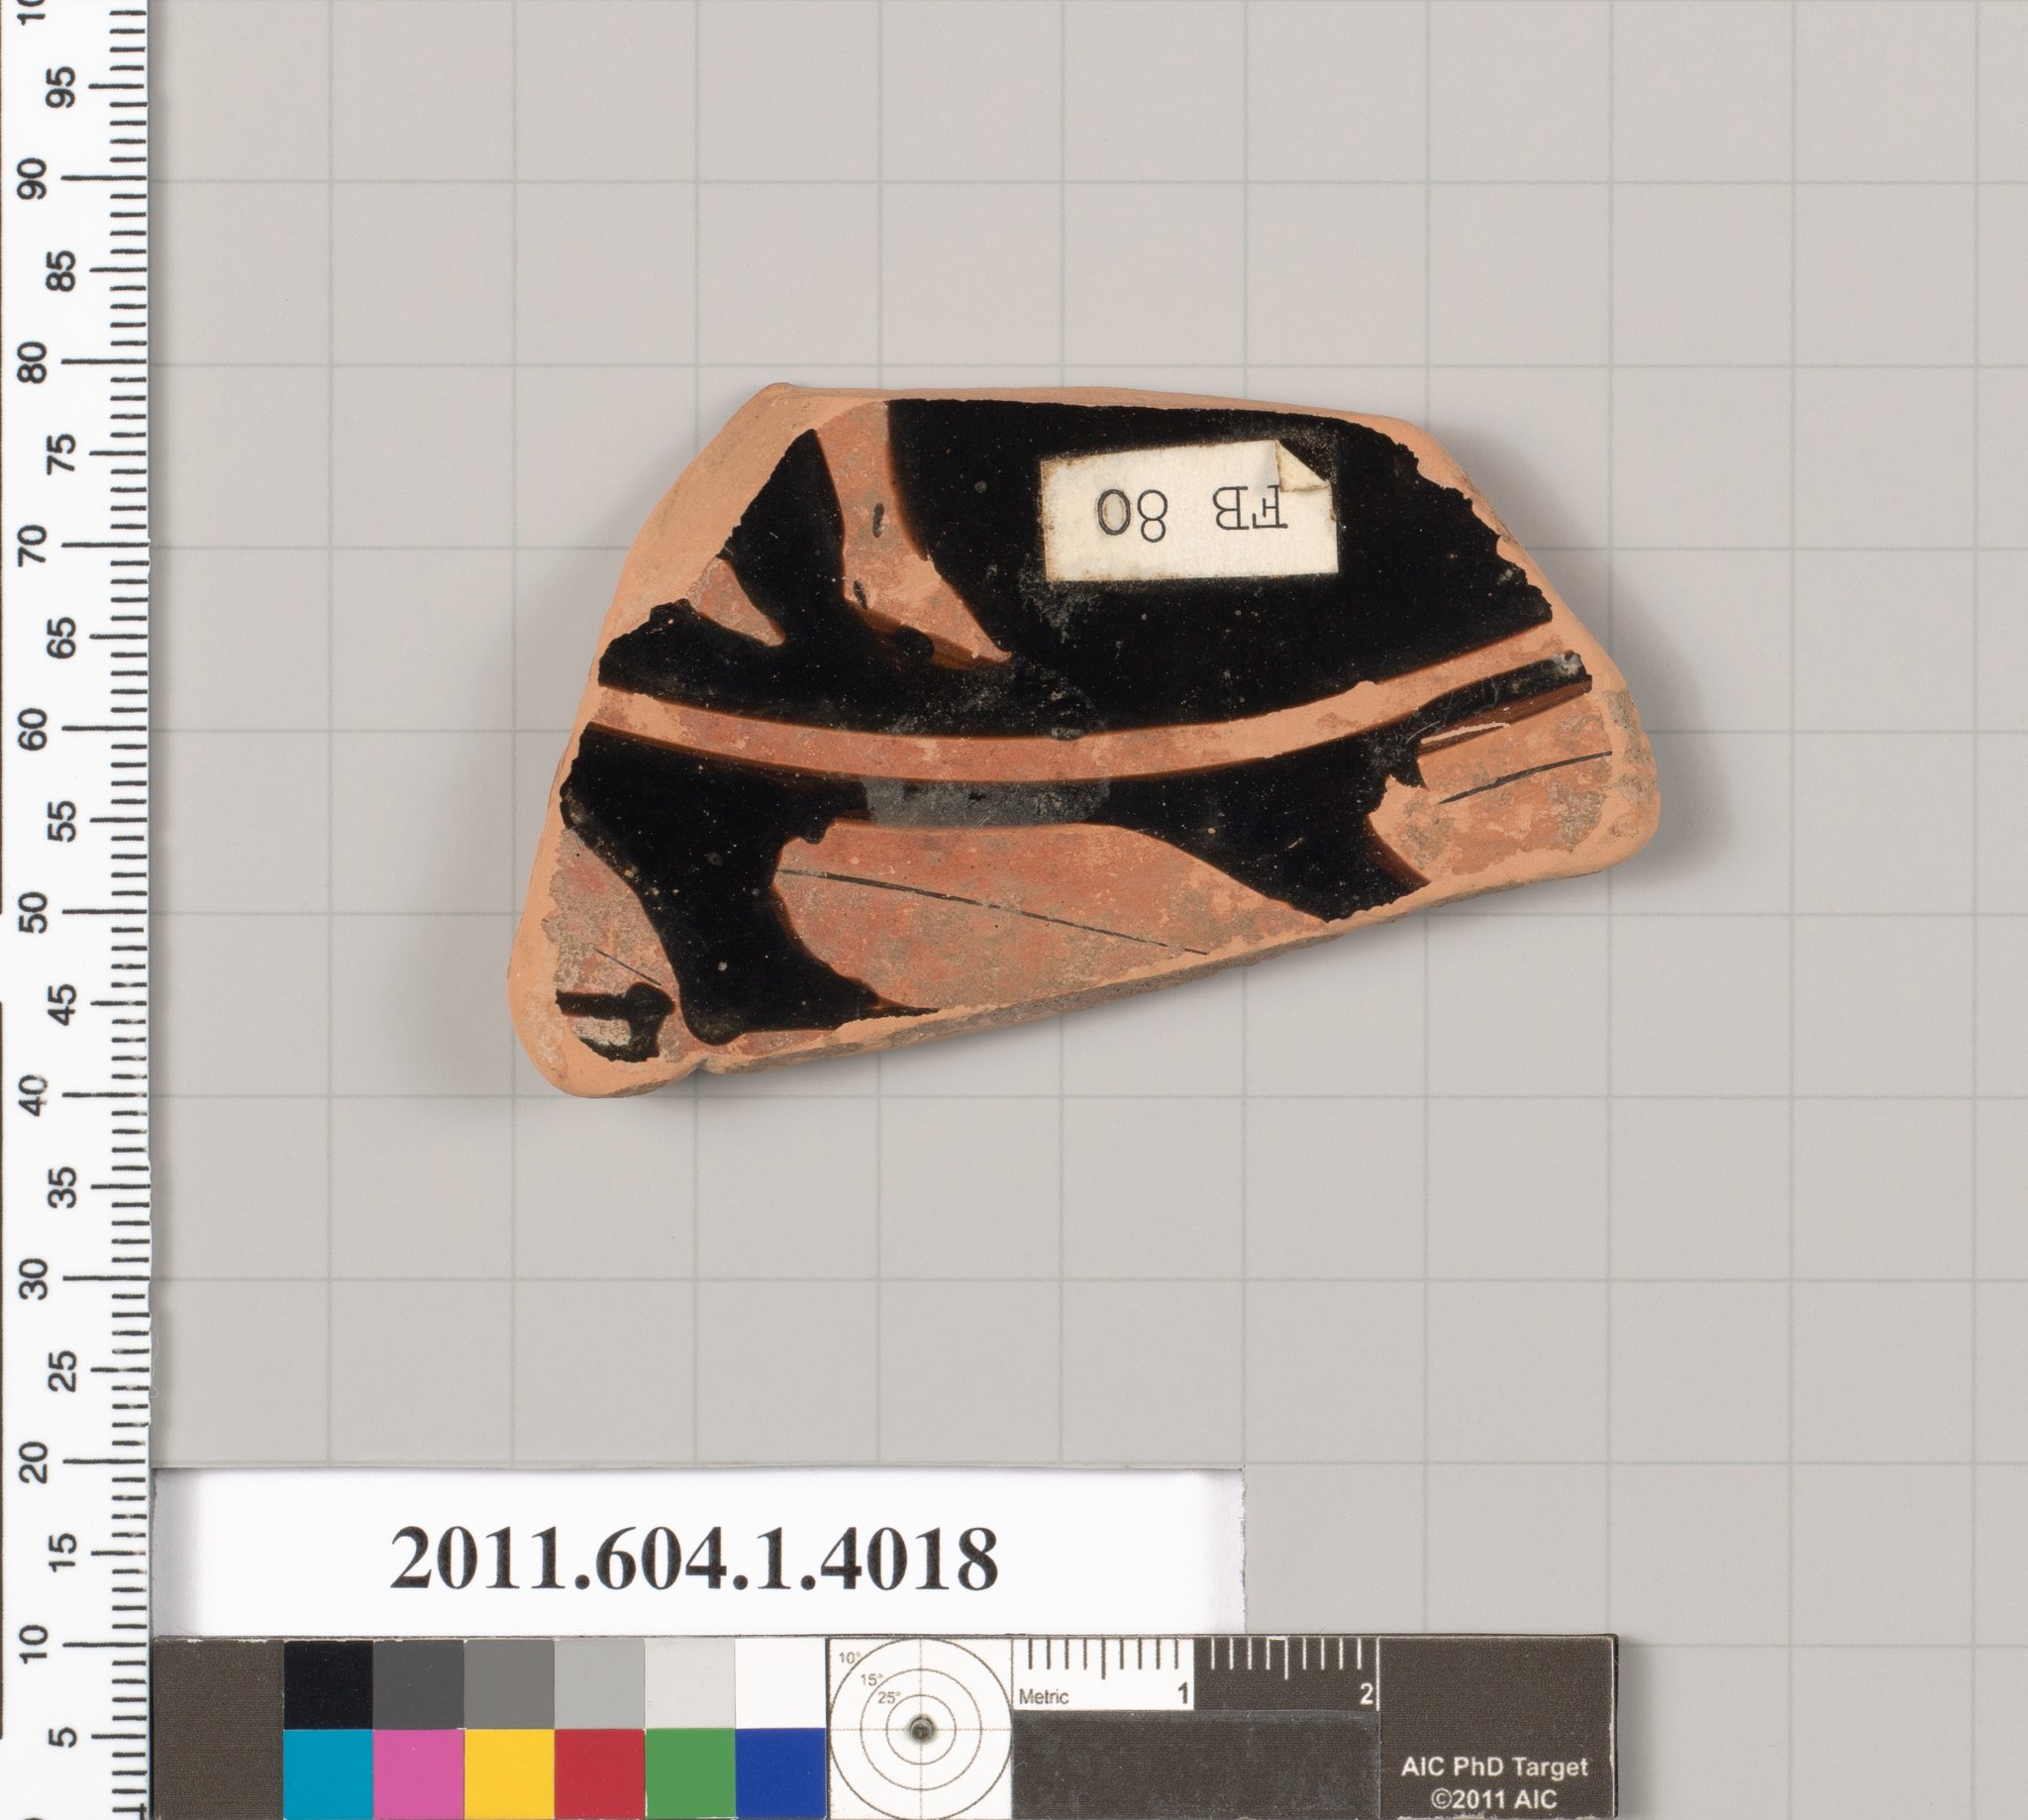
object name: kylix fragment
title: Terracotta fragment of a kylix (drinking cup)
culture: greek, attic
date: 460-440 BCE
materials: terracotta